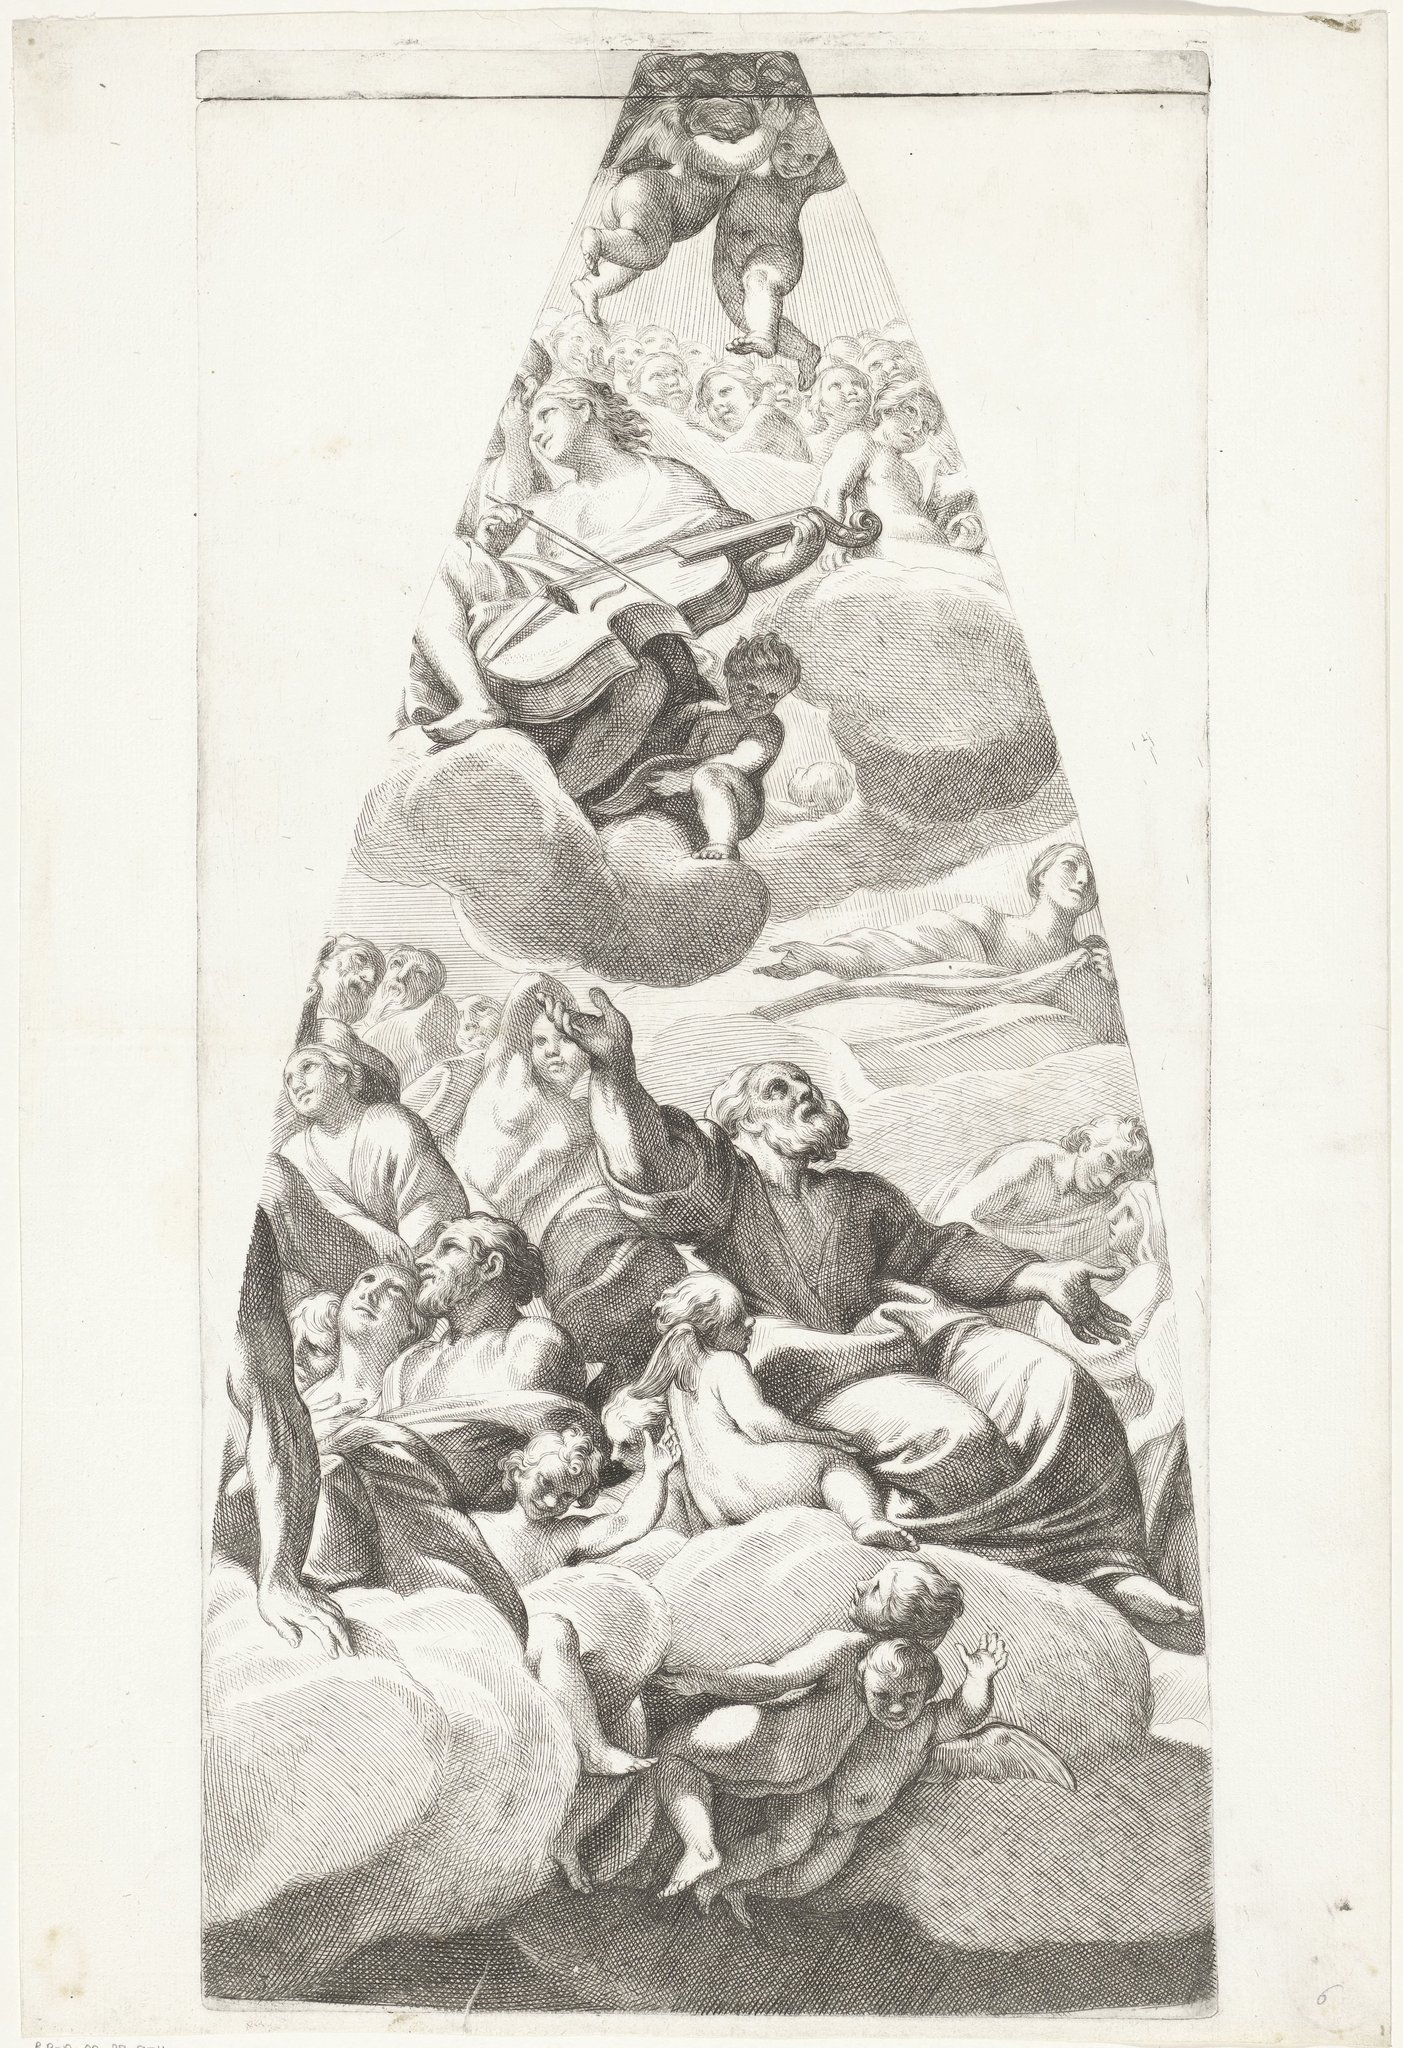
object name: print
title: Hemelvaart van Maria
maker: carlo cesio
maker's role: painter, print maker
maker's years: 1622-1682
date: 1636-1686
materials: paper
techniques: engraving, etching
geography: italy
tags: angels singing, making music, saints, joseph (not in biblical context), angels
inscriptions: collector's mark: Lugt 240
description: Prent uit een reeks van 8 prenten naar de fresco's door Giovanni Lanfranco in de koepel van de San Andrea della Valle te Rome.